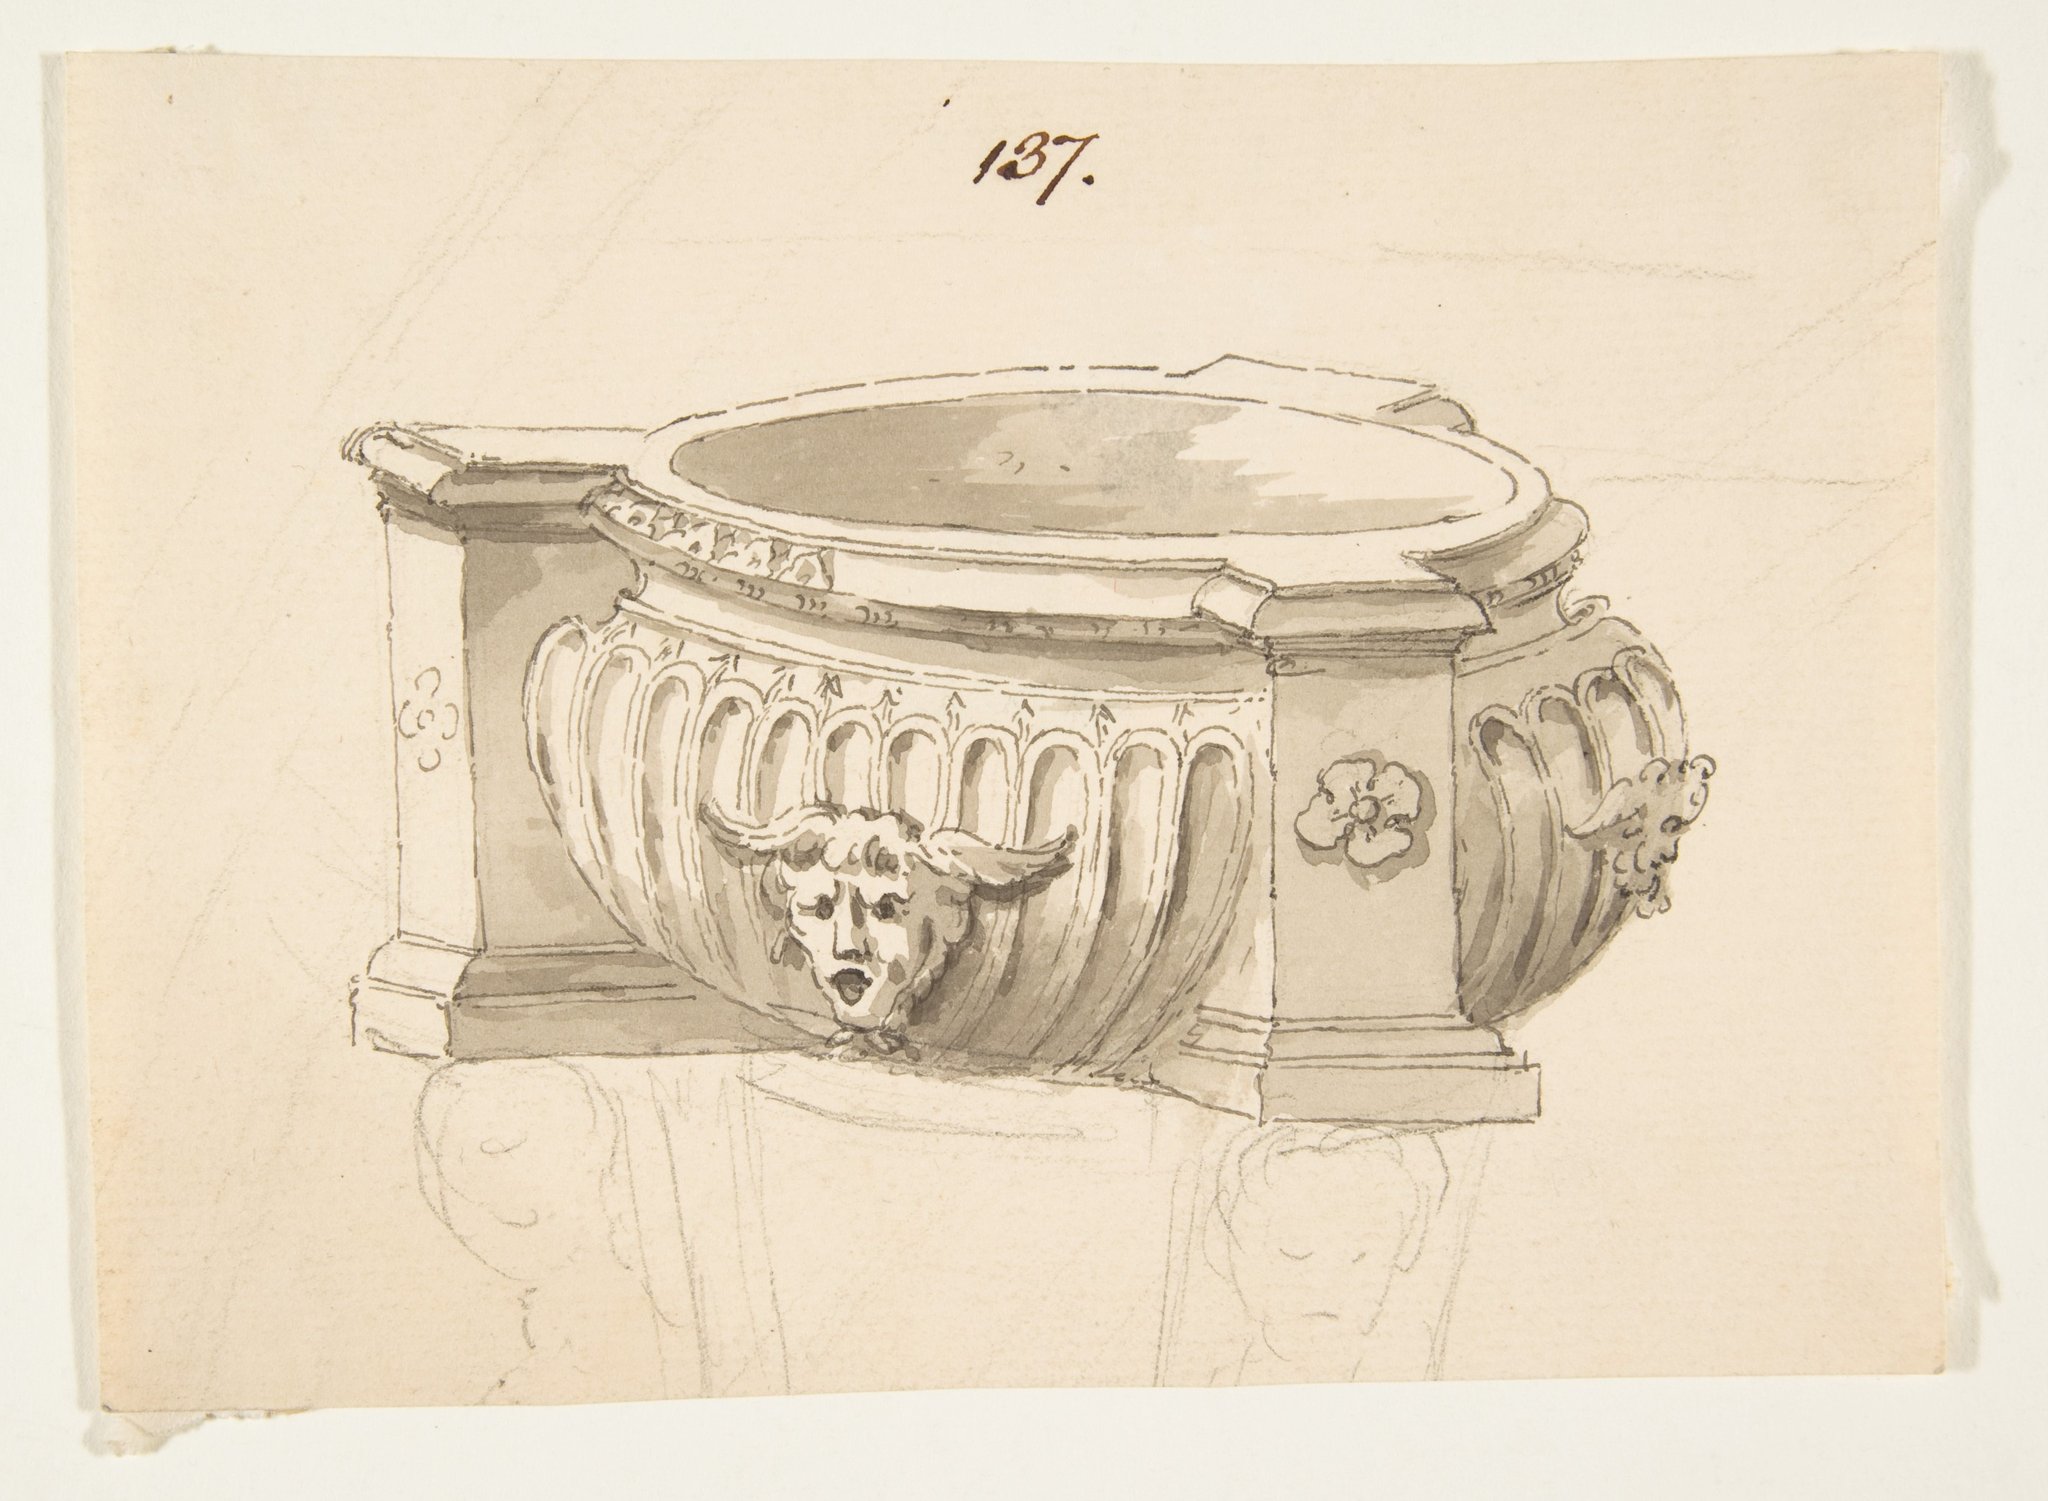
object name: drawing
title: Design for a Vessel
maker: anonymous, french, 18th century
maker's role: artist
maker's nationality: french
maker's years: 1700-1800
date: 1701-1800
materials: graphite, ink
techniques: brush, pen, wash